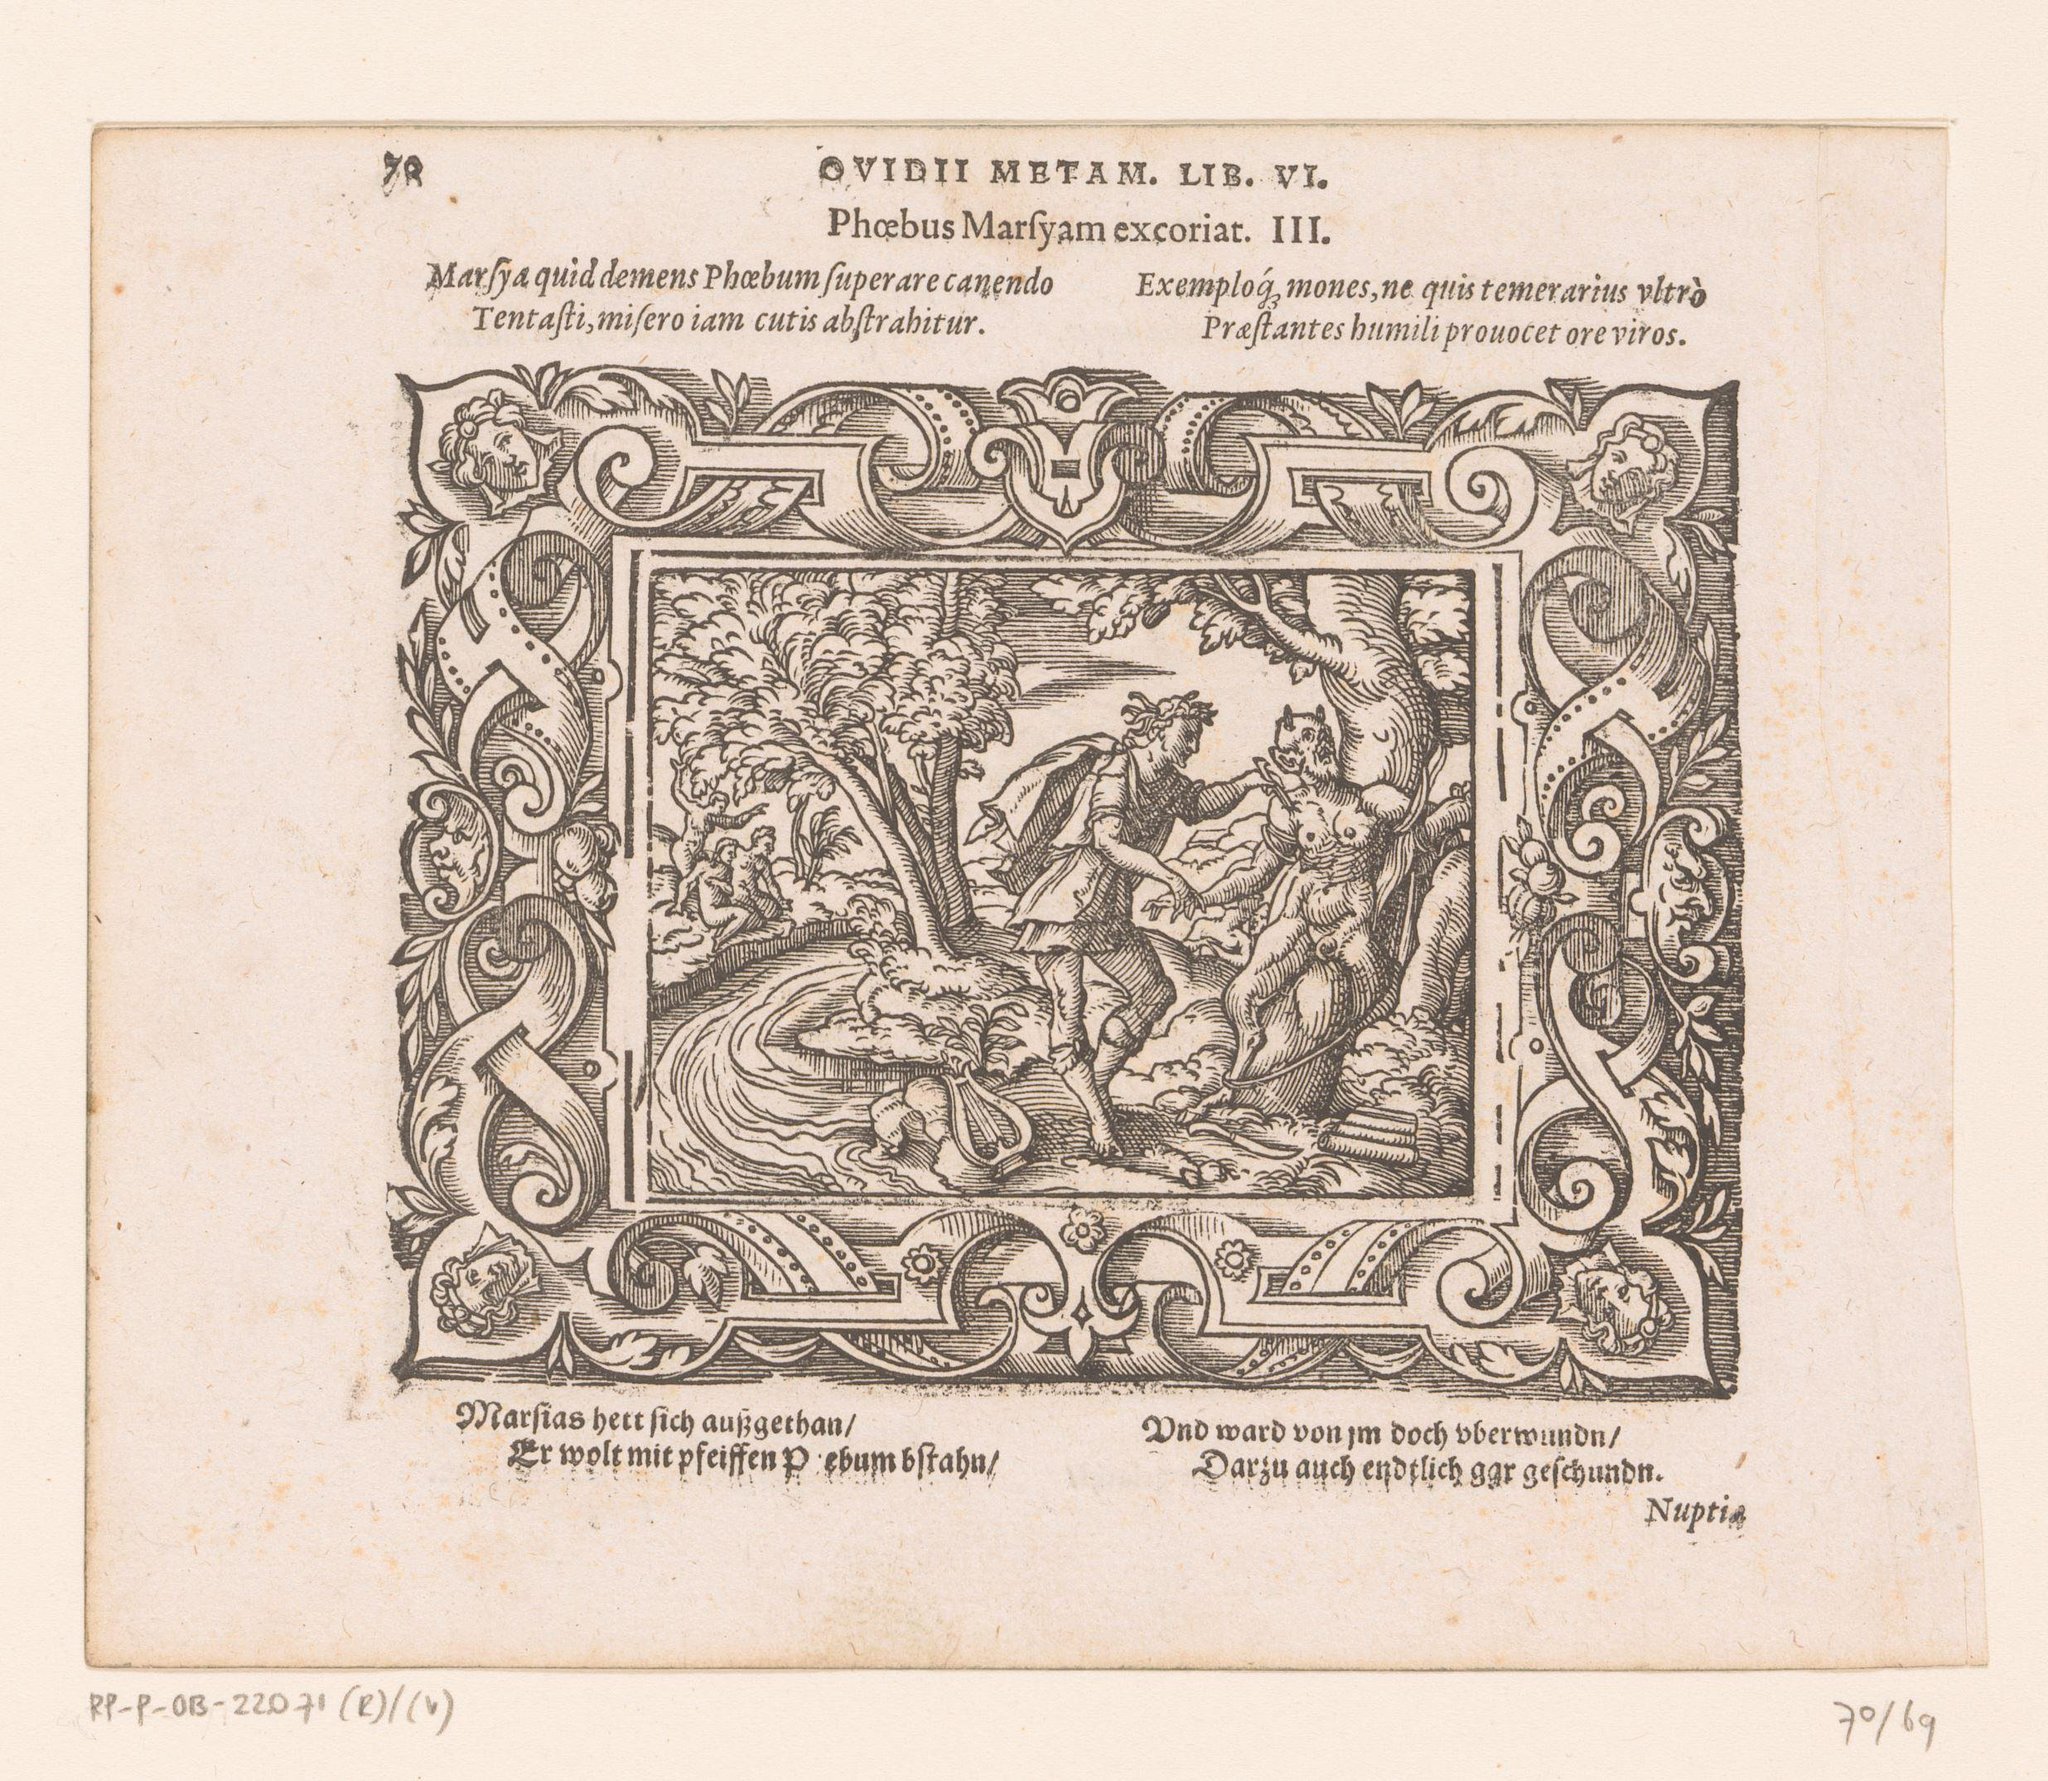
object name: book illustration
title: Apollo vilt Marsyas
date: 1569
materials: paper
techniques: letterpress printing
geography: frankfurt am main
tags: scrollwork, strapwork ~ ornament, punishment of marsyas: he is flayed by apollo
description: Illustratie bij de Metamorfosen van Ovidius, afkomstig uit de publicatie: Posthius, Johannes. Tetrasticha in Ovidii metam. Frankfurt am Main: Georg Rab en Sigmund Feyerabend en erven Weigand Han, 1569. De voorstellingen en ornamentranden van deze boekillustraties zijn van twee aparte blokken gedrukt. Beide werden afzonderlijk van elkaar ook gebruikt voor andere publicaties, en de ornamentranden werden eveneens binnen deze publicatie meerdere keren gebruikt.